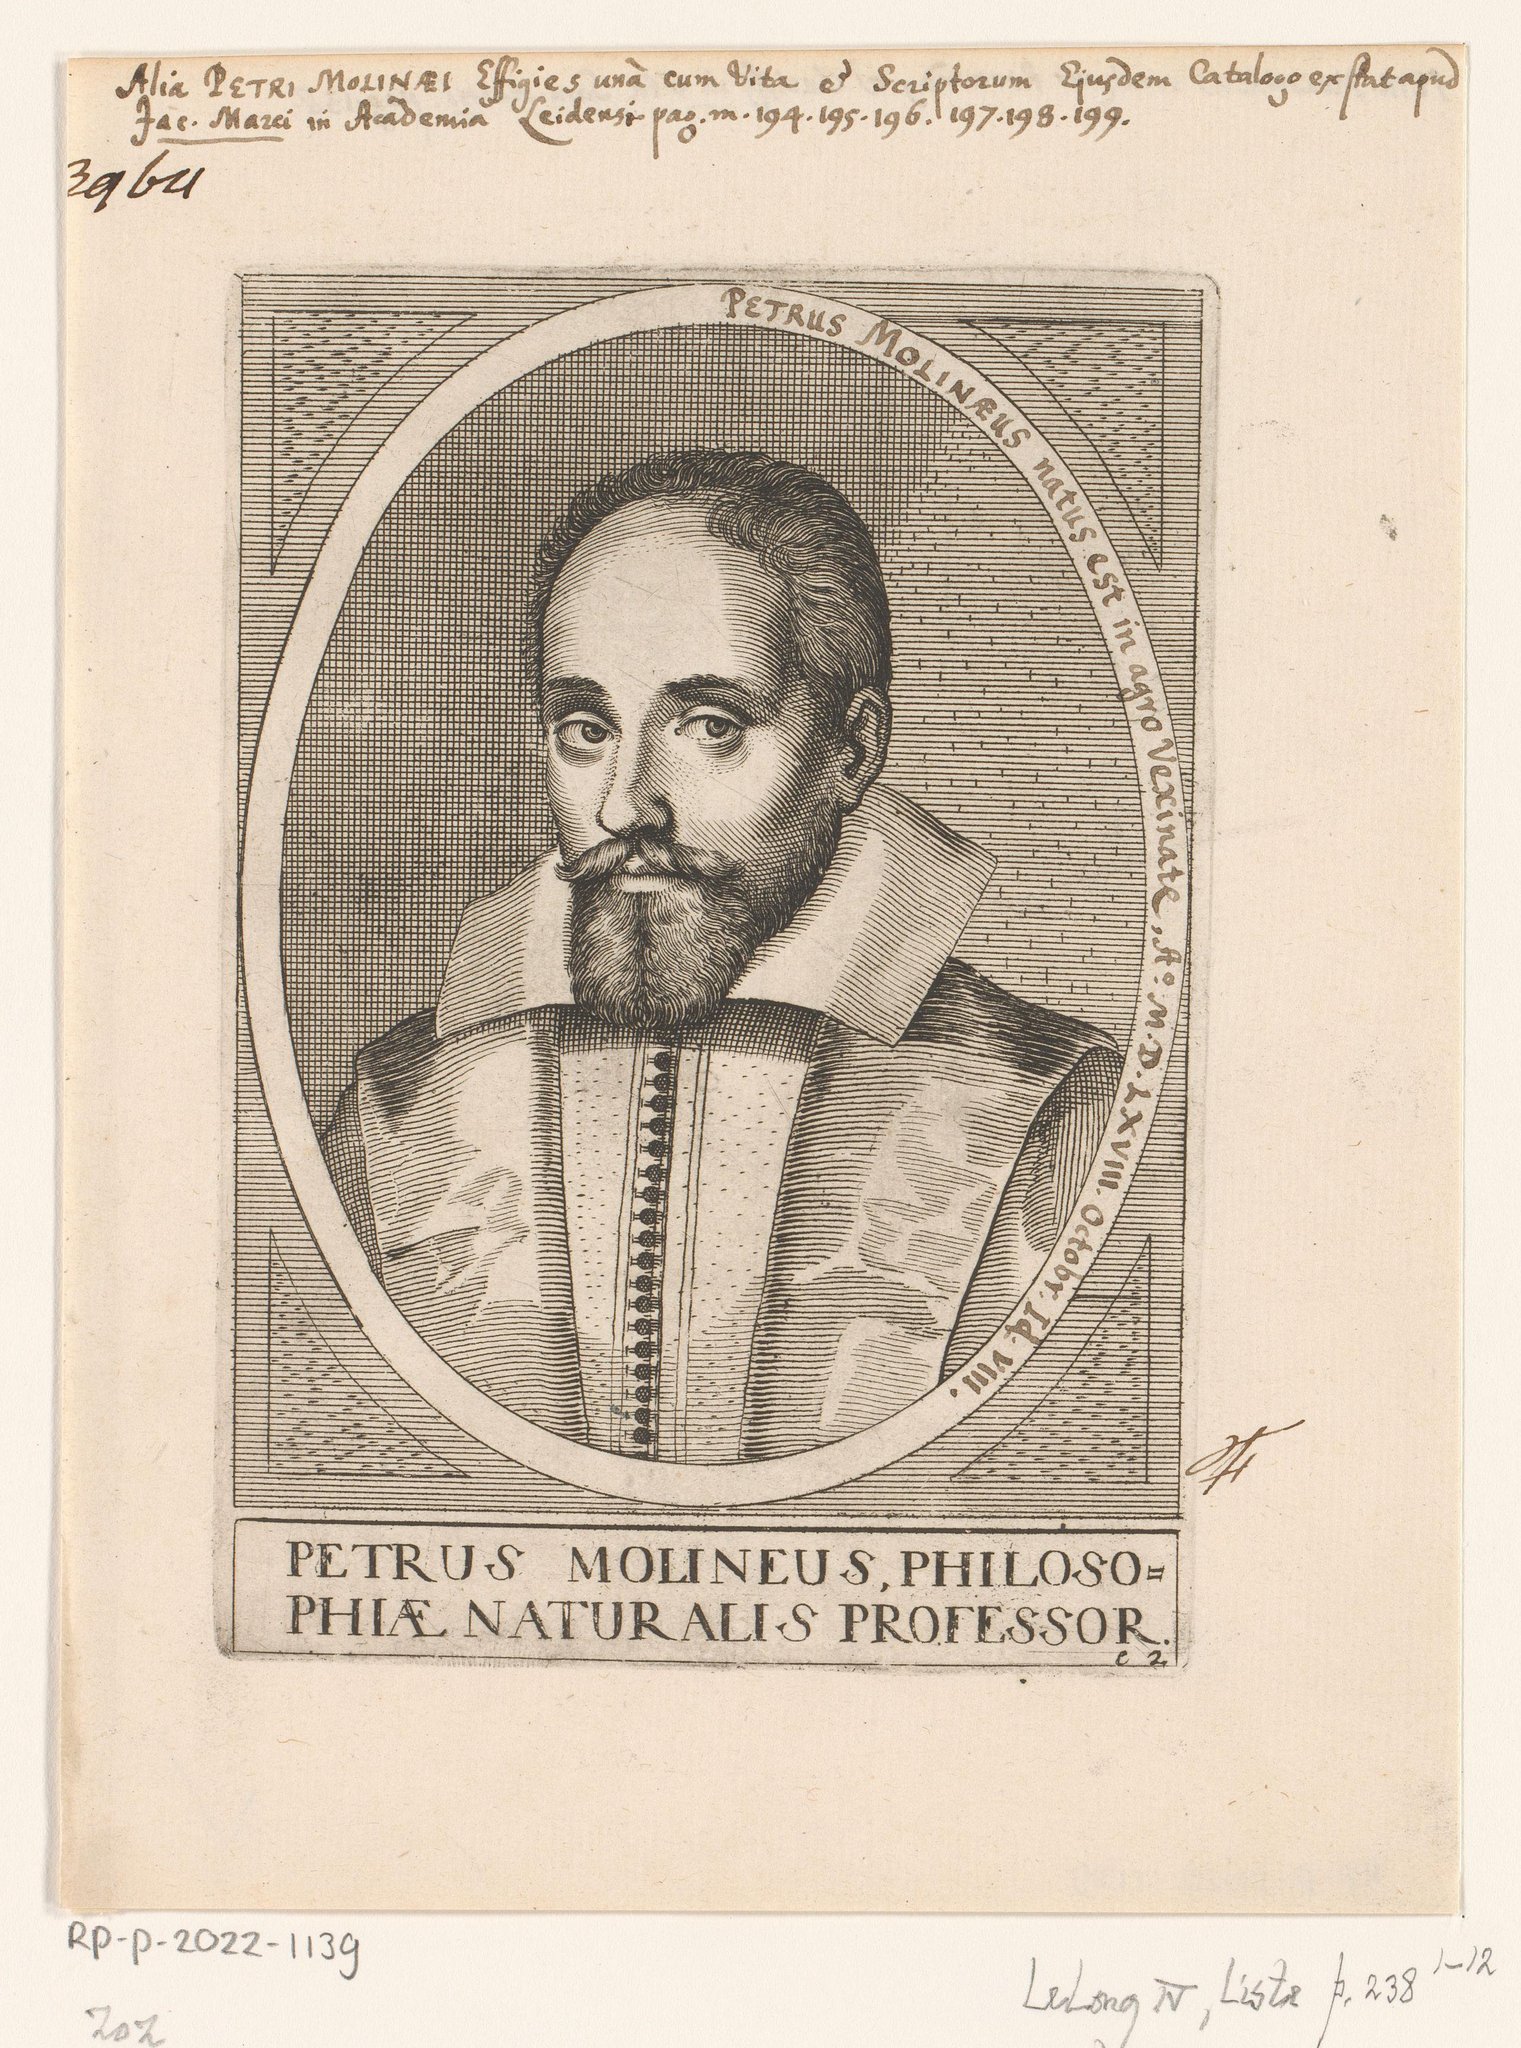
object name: print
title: Portret van Pierre du Moulin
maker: Anonymous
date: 1650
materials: paper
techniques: engraving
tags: minister ~ government, historical persons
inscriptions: inscription: ‘Petr. Molinaeus [...] pag. 138.’, inscription: ‘Alia Petri [...] 198.199.’, collector's mark: Lugt 2228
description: Prent waarschijnlijk uit: Boissard, Jean Jacques. Bibliotheca chalcographica (...). Frankfurt am Main: Johannes Ammon, 1650, dl. 6.